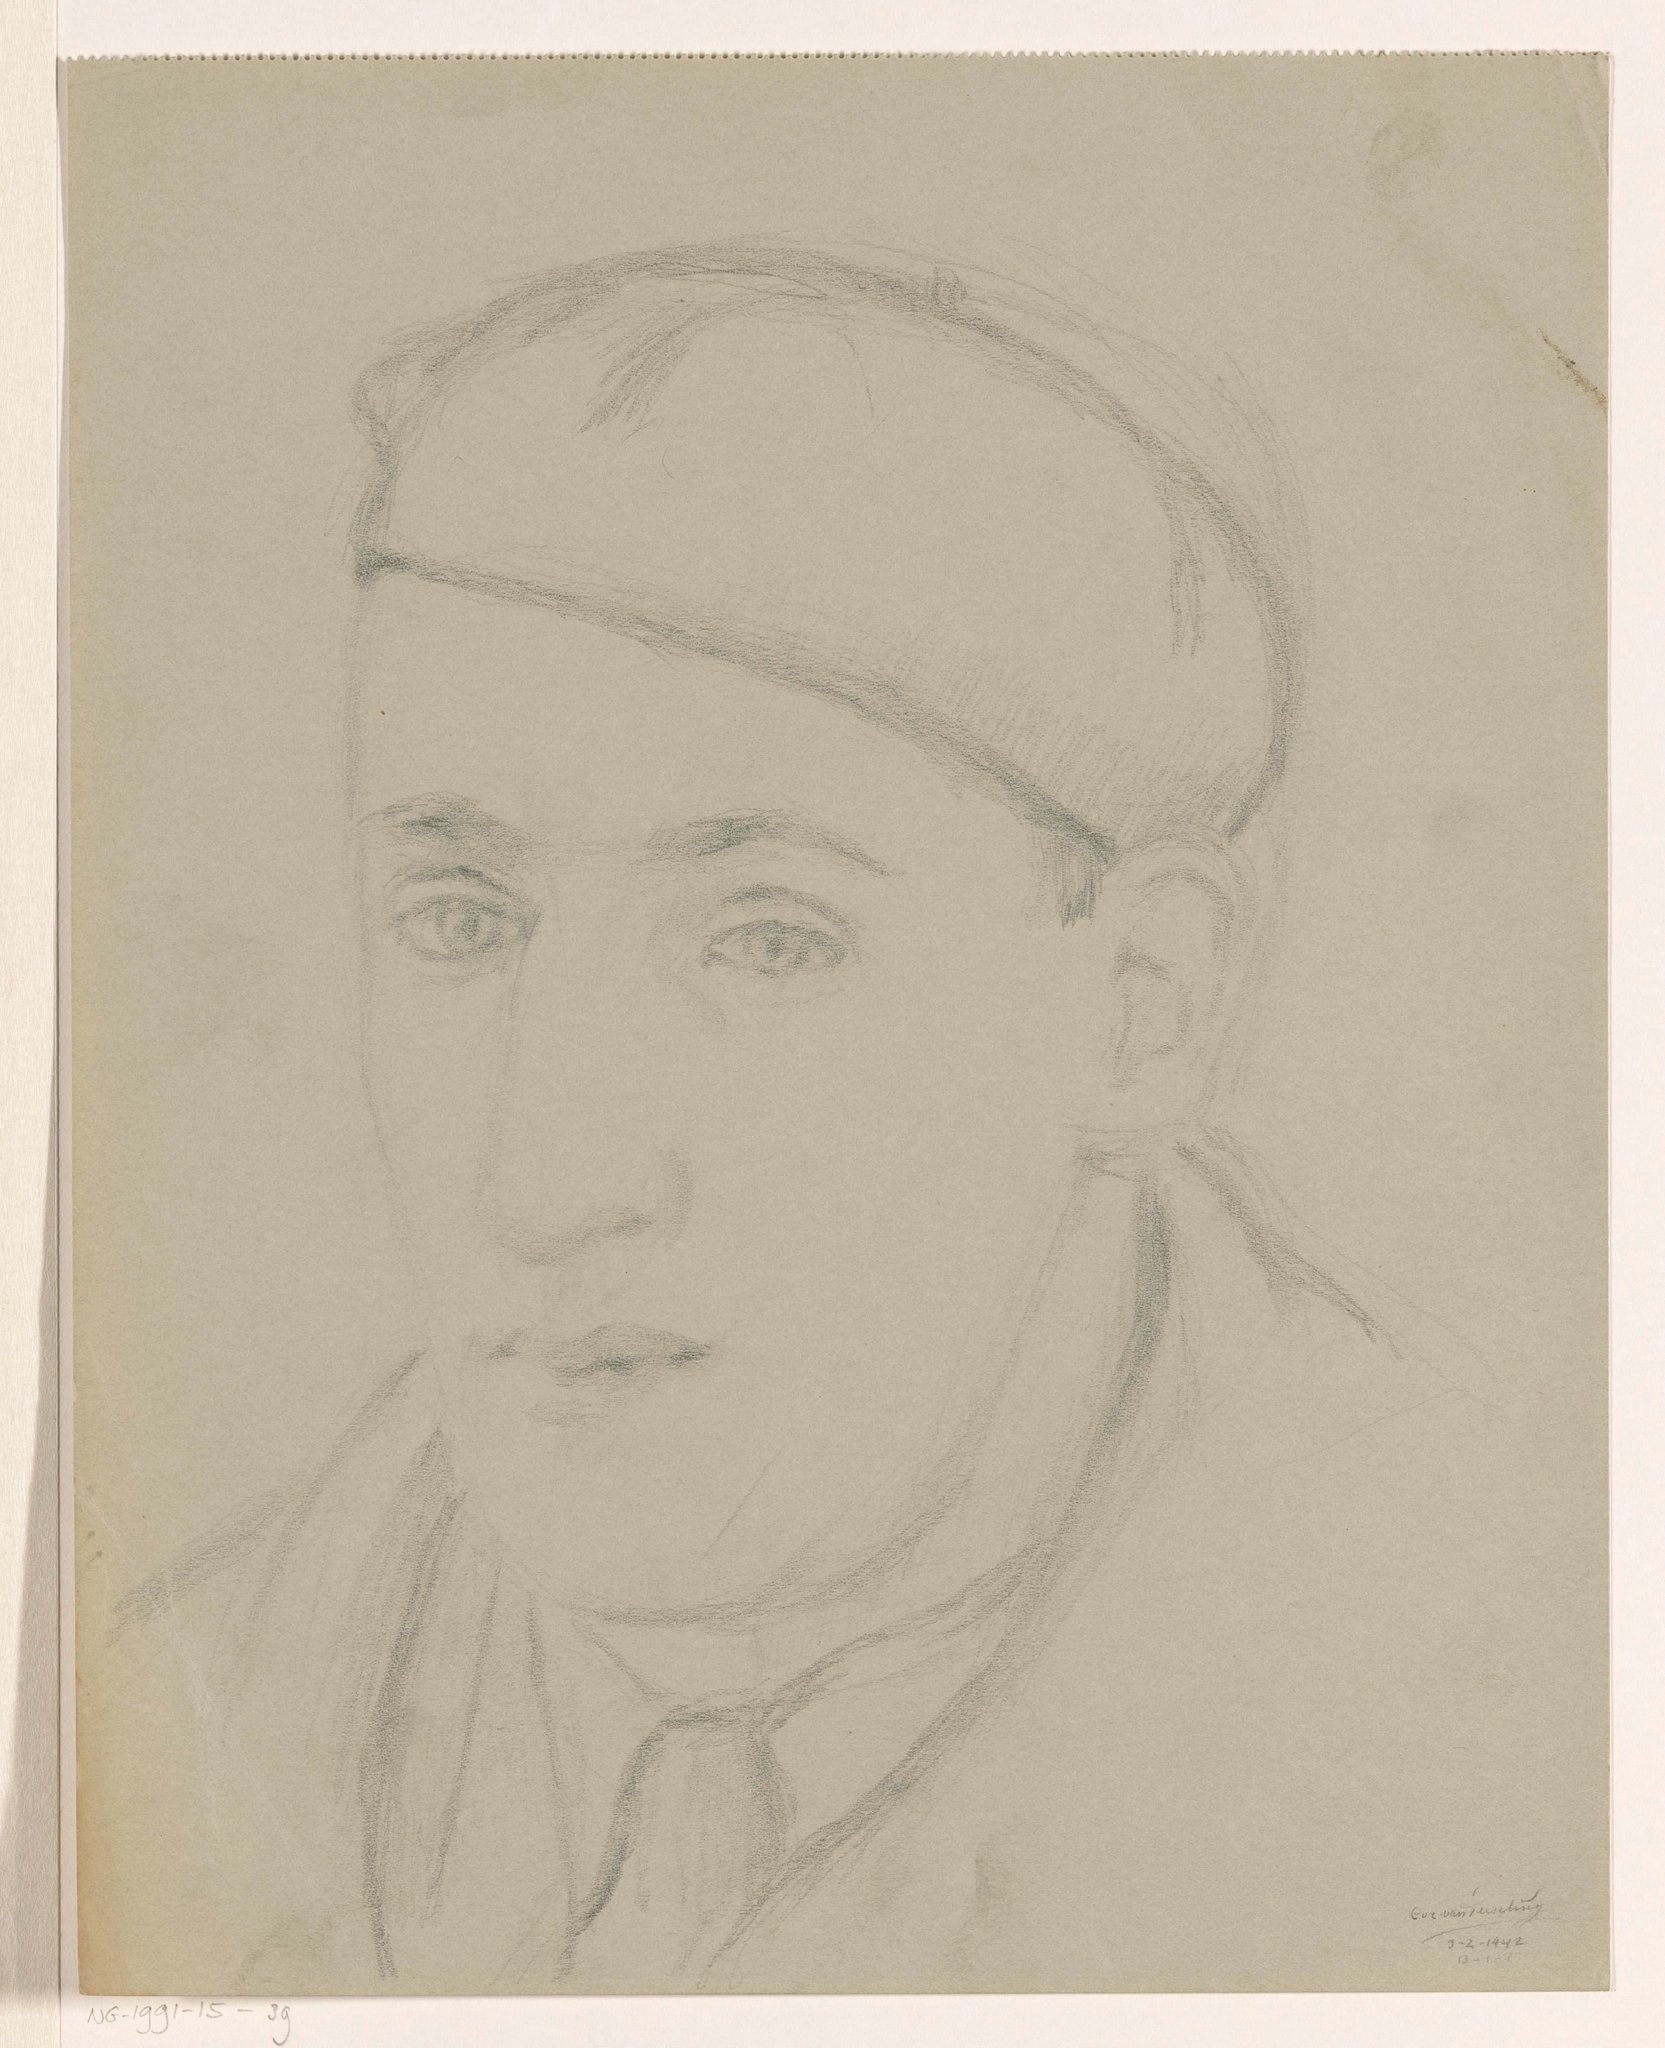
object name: drawing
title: Zelfportretten van Cor van Teeseling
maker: cor van teeseling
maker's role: draughtsman, sculptor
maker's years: 1915-1942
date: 1942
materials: paper, pencil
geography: weteringschans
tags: amsterdam, draughtsman, sculptor, cor van teeseling, historical persons, prisoner in cell or locked place, portrait, self-portrait of draughtsman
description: Zelfportret van Cor van Teeseling met pet: B-1-1, 9 februari. Getekend zelfportret van Cor van Teeseling driekwart met zijn hoofd met pet naar links gewend.